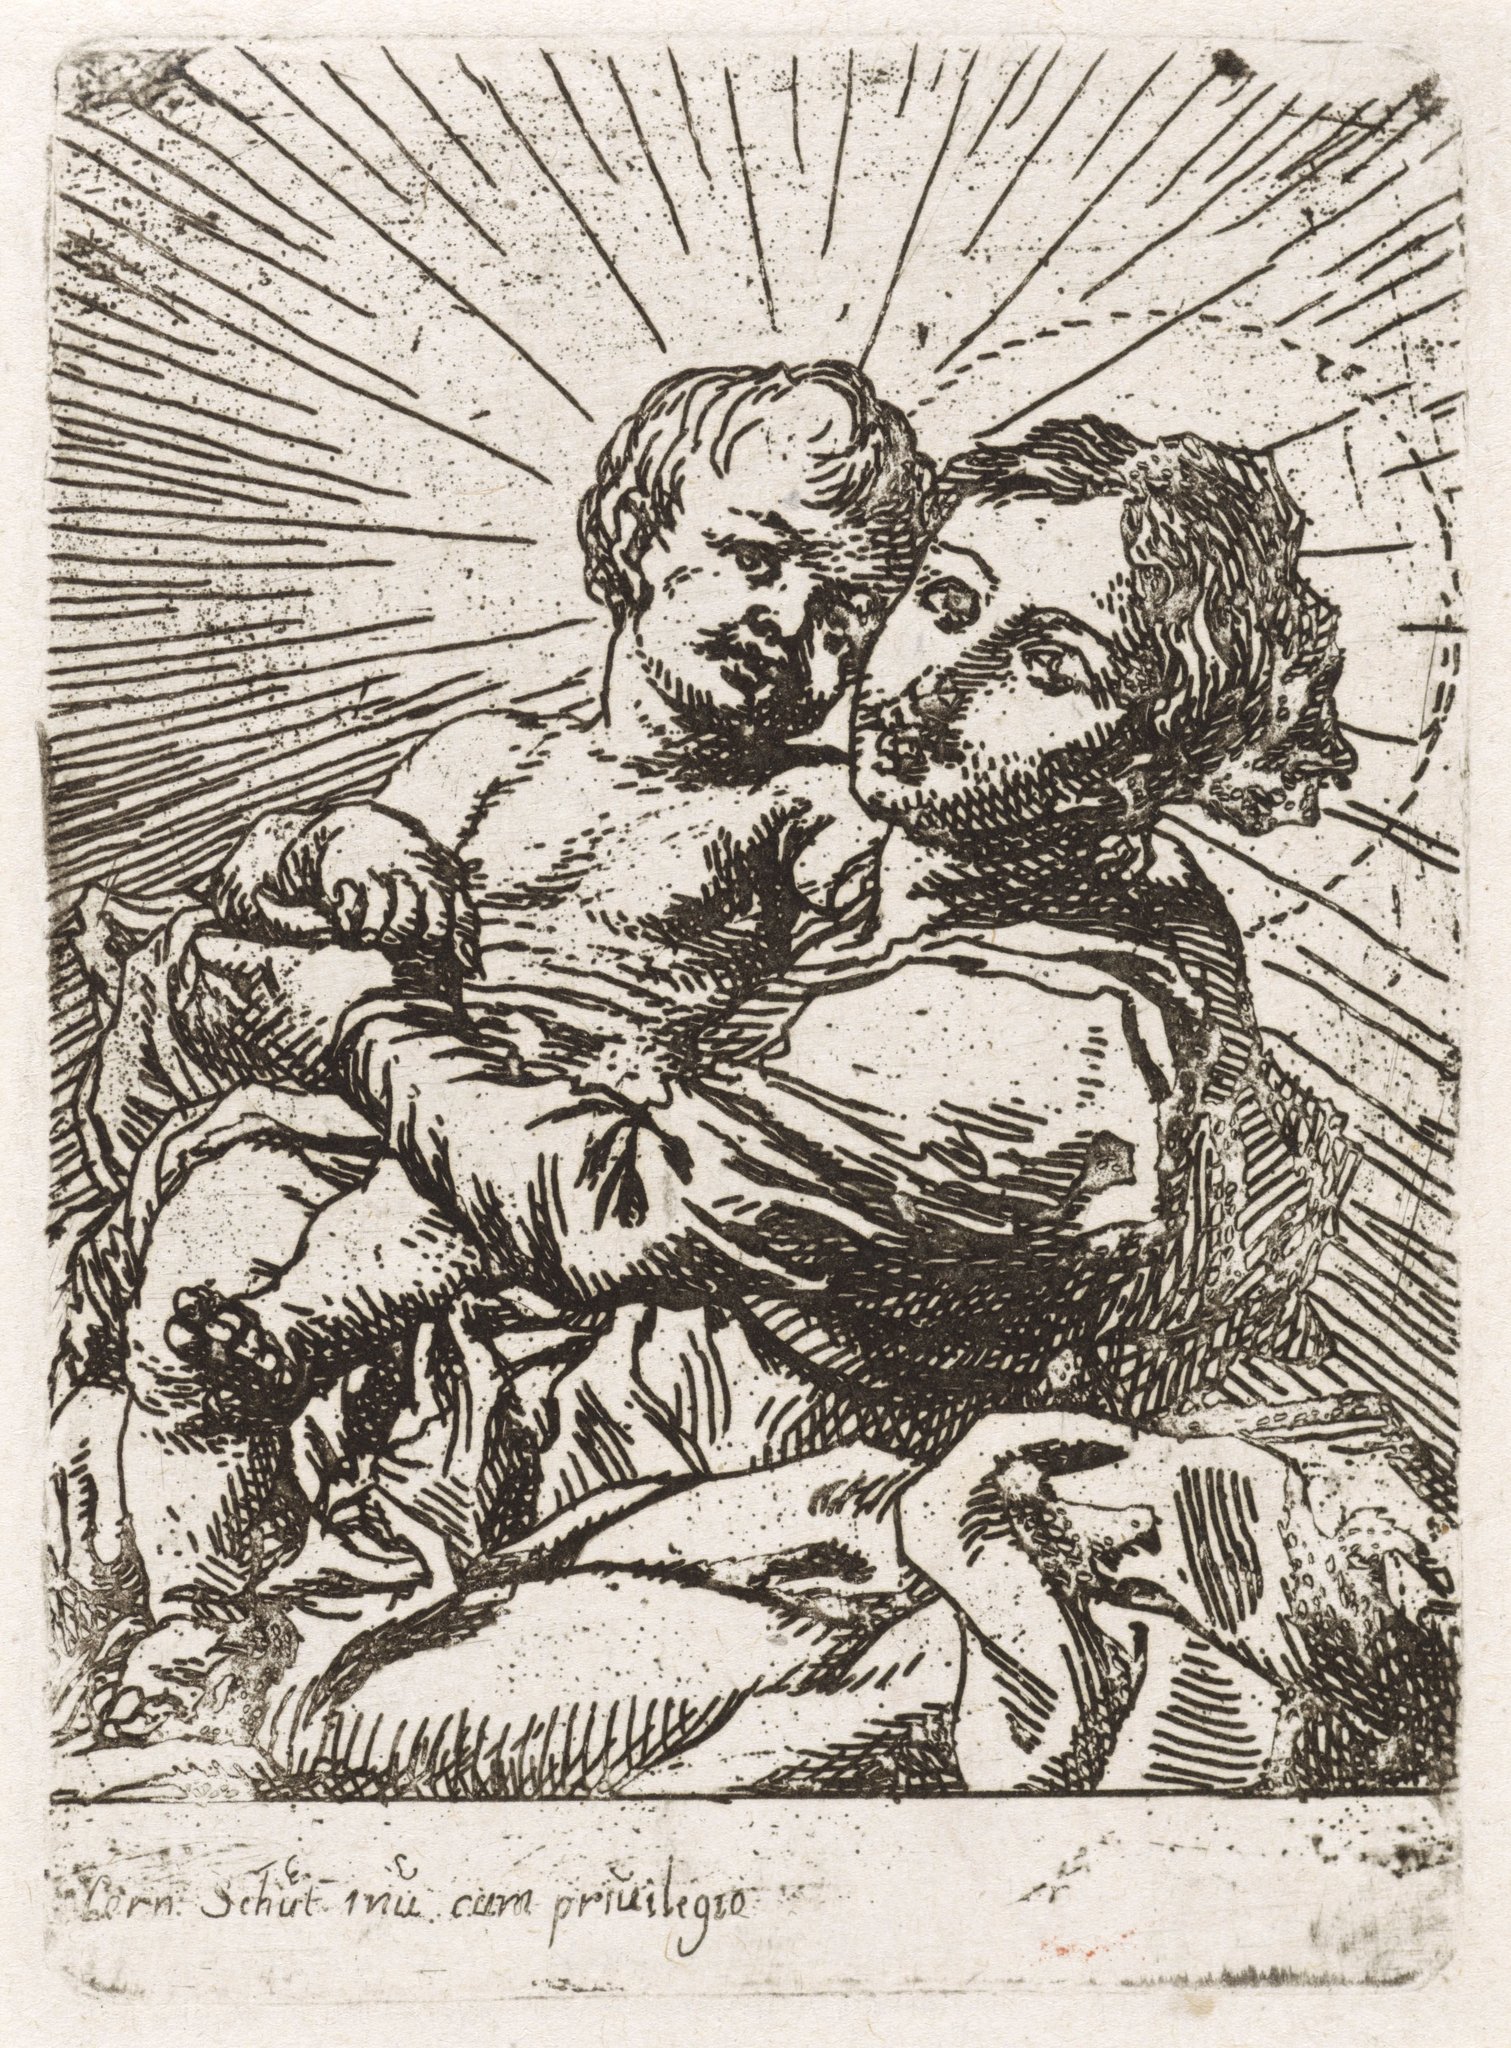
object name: print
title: Madonna met kind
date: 1618-1655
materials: paper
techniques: etching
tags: madonna: mary sitting or enthroned, the christ-child in her lap (or in front of her bosom) (mary sometimes represented half-length)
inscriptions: collector's mark: Lugt 240